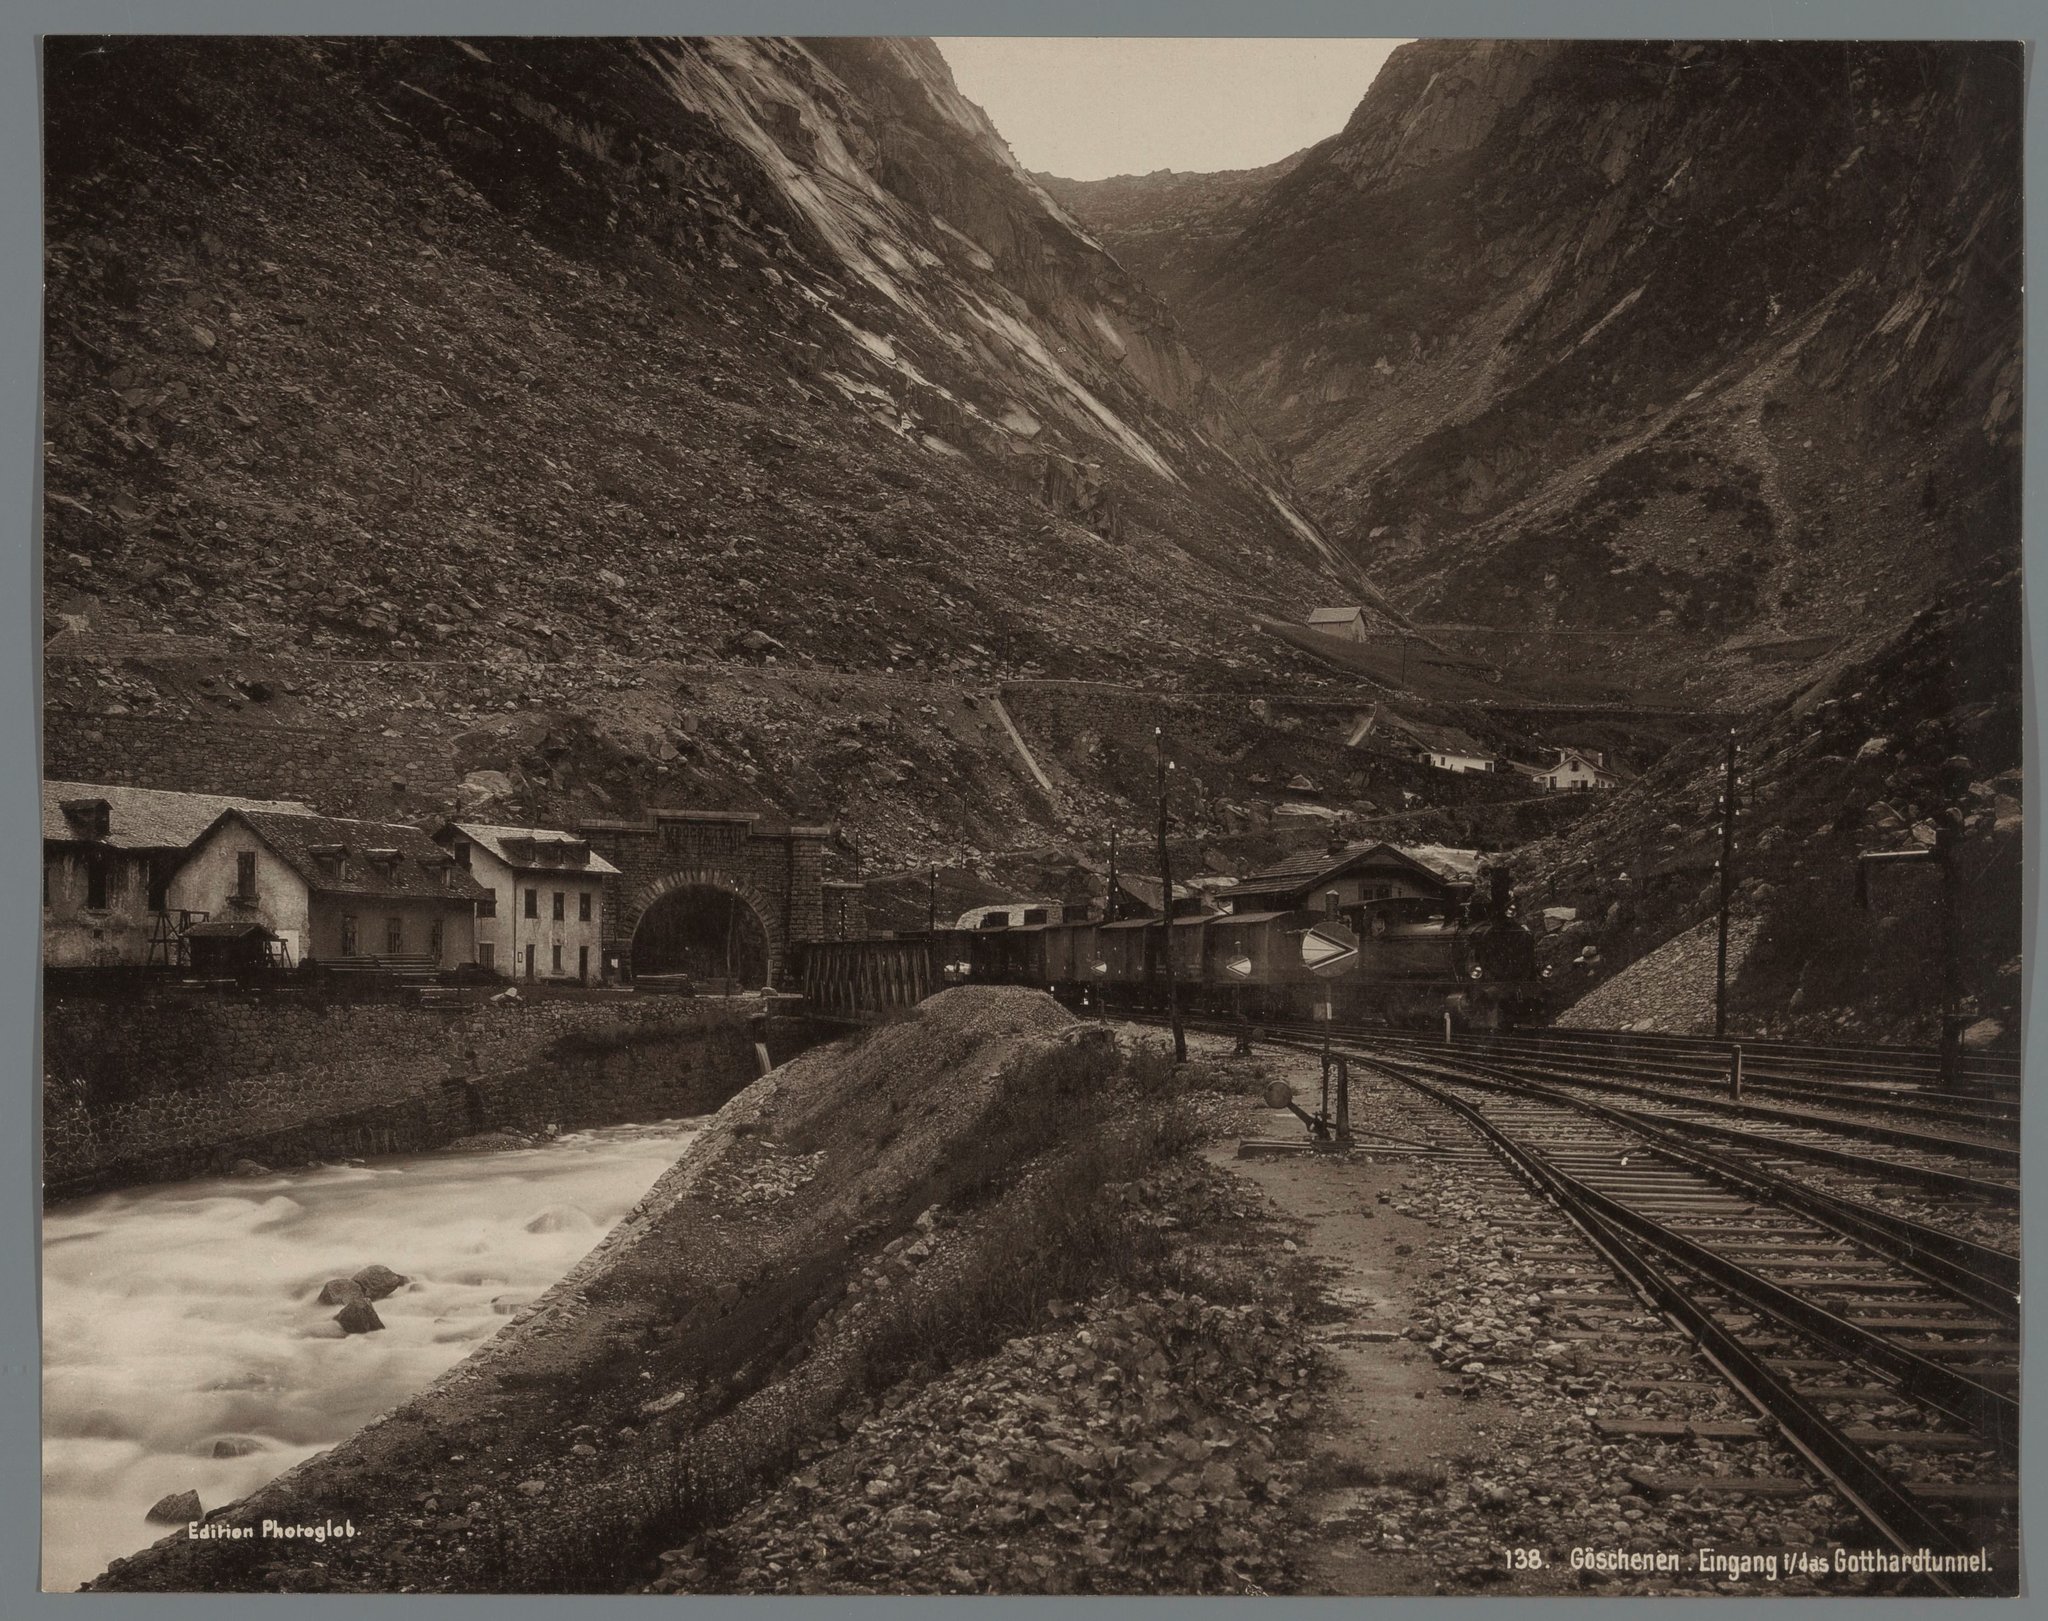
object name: photomechanical print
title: Göschenen, eingang i/das Gotthardtunnel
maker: Anonymous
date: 1895-1930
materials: paper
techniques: photograph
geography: zurich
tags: underground road, tunnel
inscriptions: number: ‘138.’